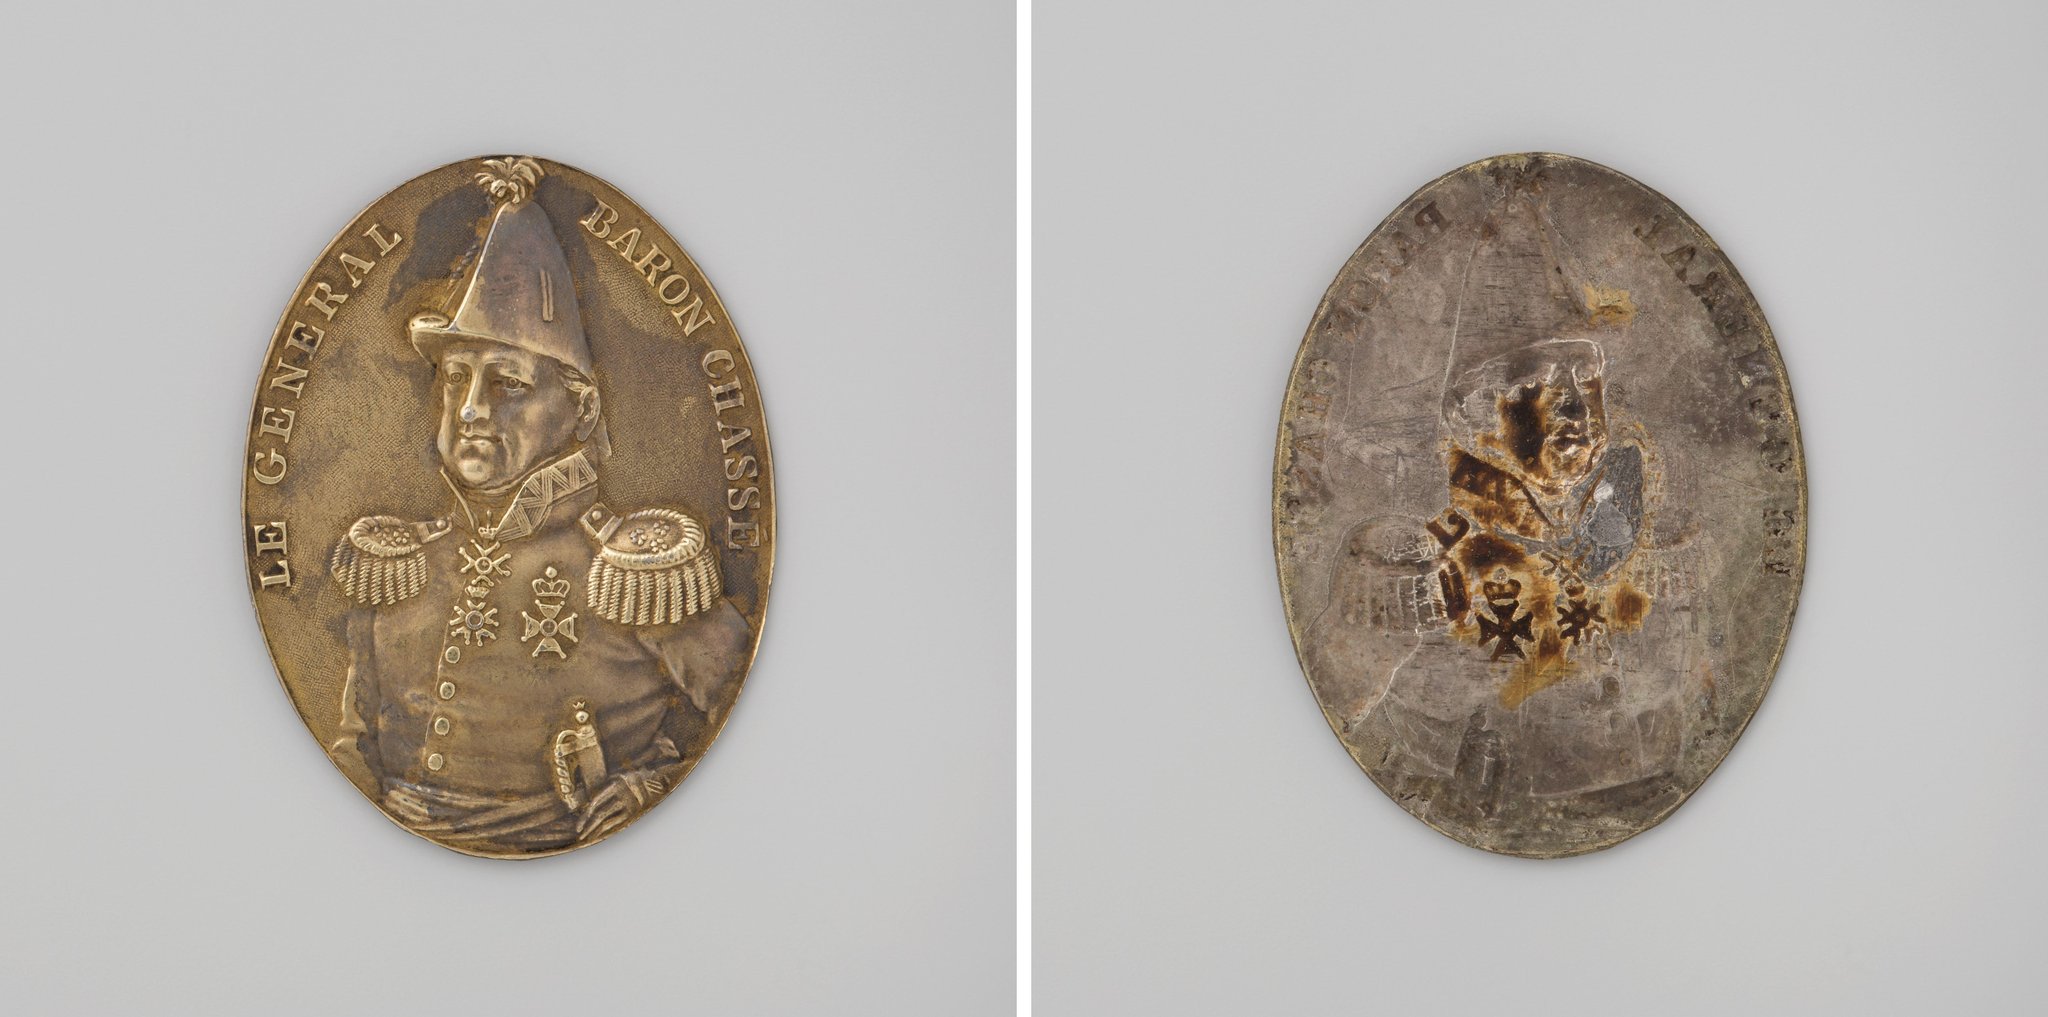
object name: history medal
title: David Hendrik baron Chassé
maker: Anonymous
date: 1830-1832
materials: copper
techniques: repoussé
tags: david hendrik baron chassé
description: Eenzijdige koperen ovale penning. Voorzijde: borststuk man met steek op hoofd binnen omschrift. Keerzijde: blanco.